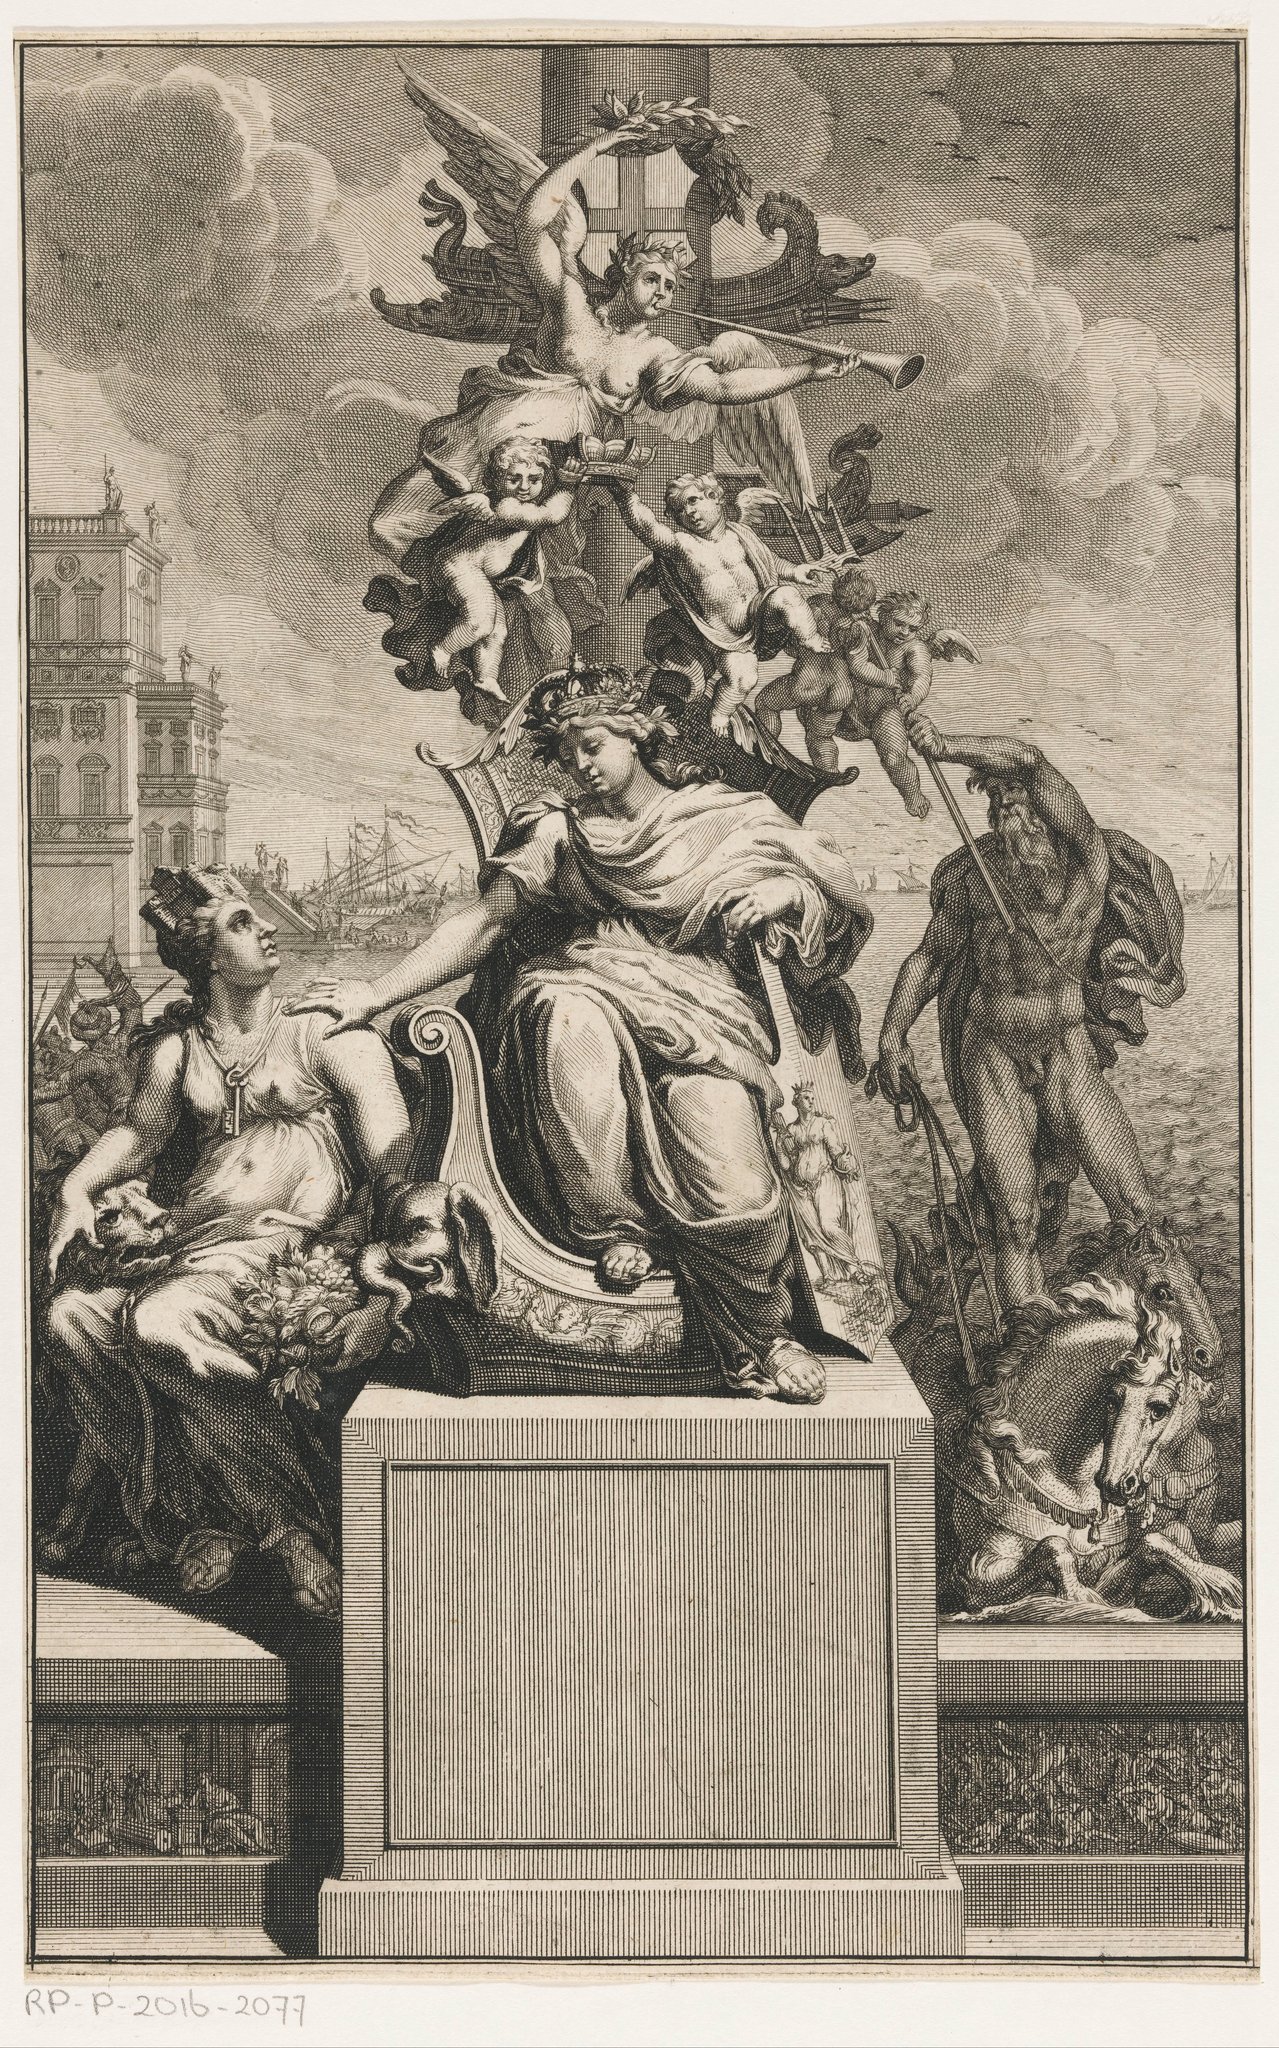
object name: print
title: Allegorische voorstelling met vrouw op troon, stedenmaagd en Neptunus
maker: Anonymous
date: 1650-1750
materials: paper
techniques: engraving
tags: (story of) neptune (poseidon), personification of a city, town-patron(ess), throne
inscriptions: collector's mark: Lugt 2228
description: Een gekroonde vrouw zit op een troon in de vorm van een boot met olifantenkop. Ze legt haar hand op de schouder van de zittende stedenmaagd met muurkroon, hoorn des overvloeds en leeuw naast haar. Rechts op zee staat Neptunus op zijn strijdwagen voortgetrokken door paarden. Boven de troon vliegen putti met een kroon en Fama met een lauwerkrans. Links in de achtergrond meren schepen aan bij een gebouw.